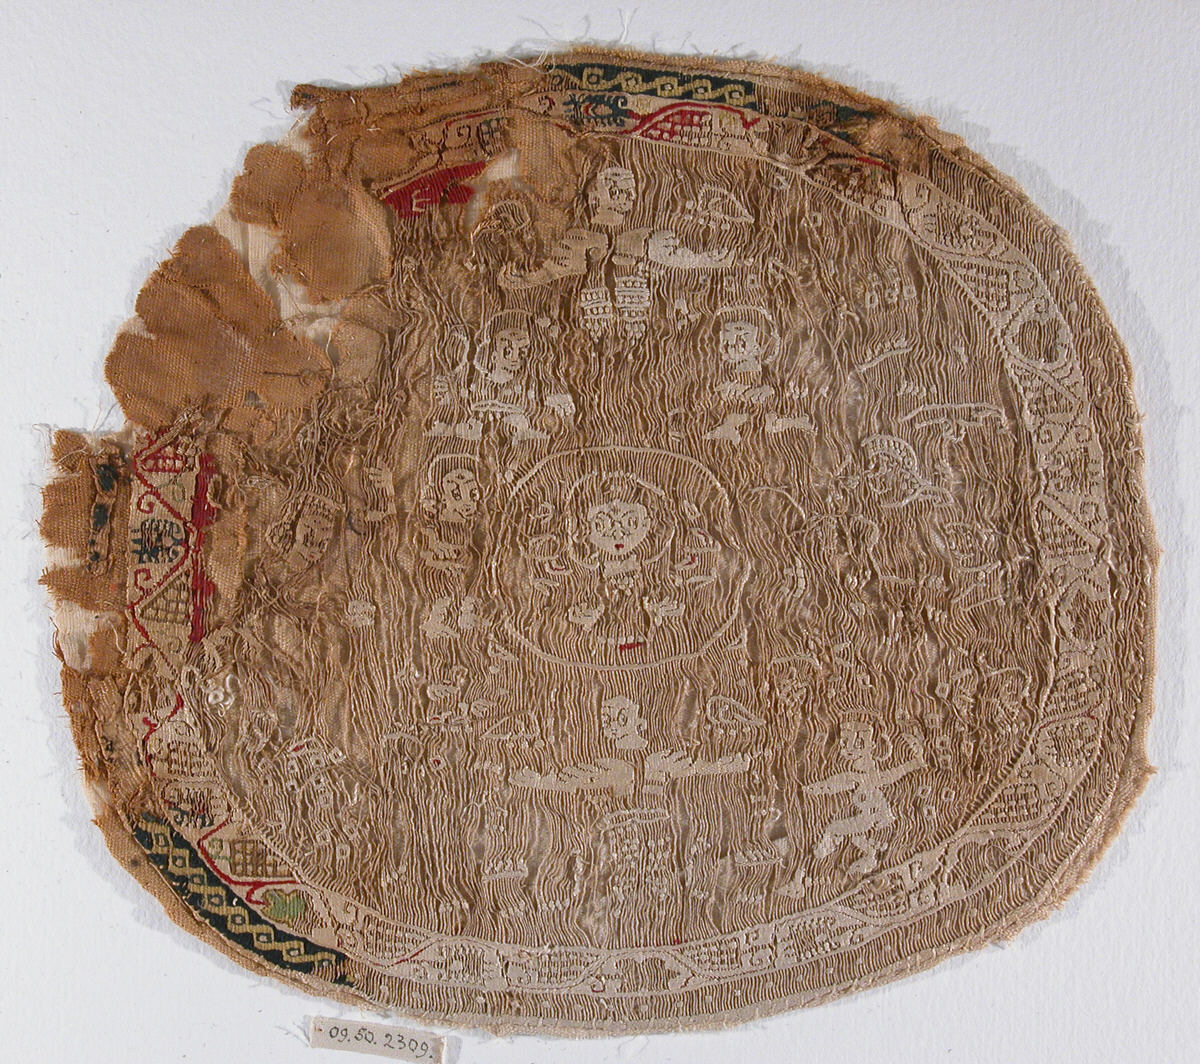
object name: roundel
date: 501-700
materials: linen, wool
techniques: weave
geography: egypt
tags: men